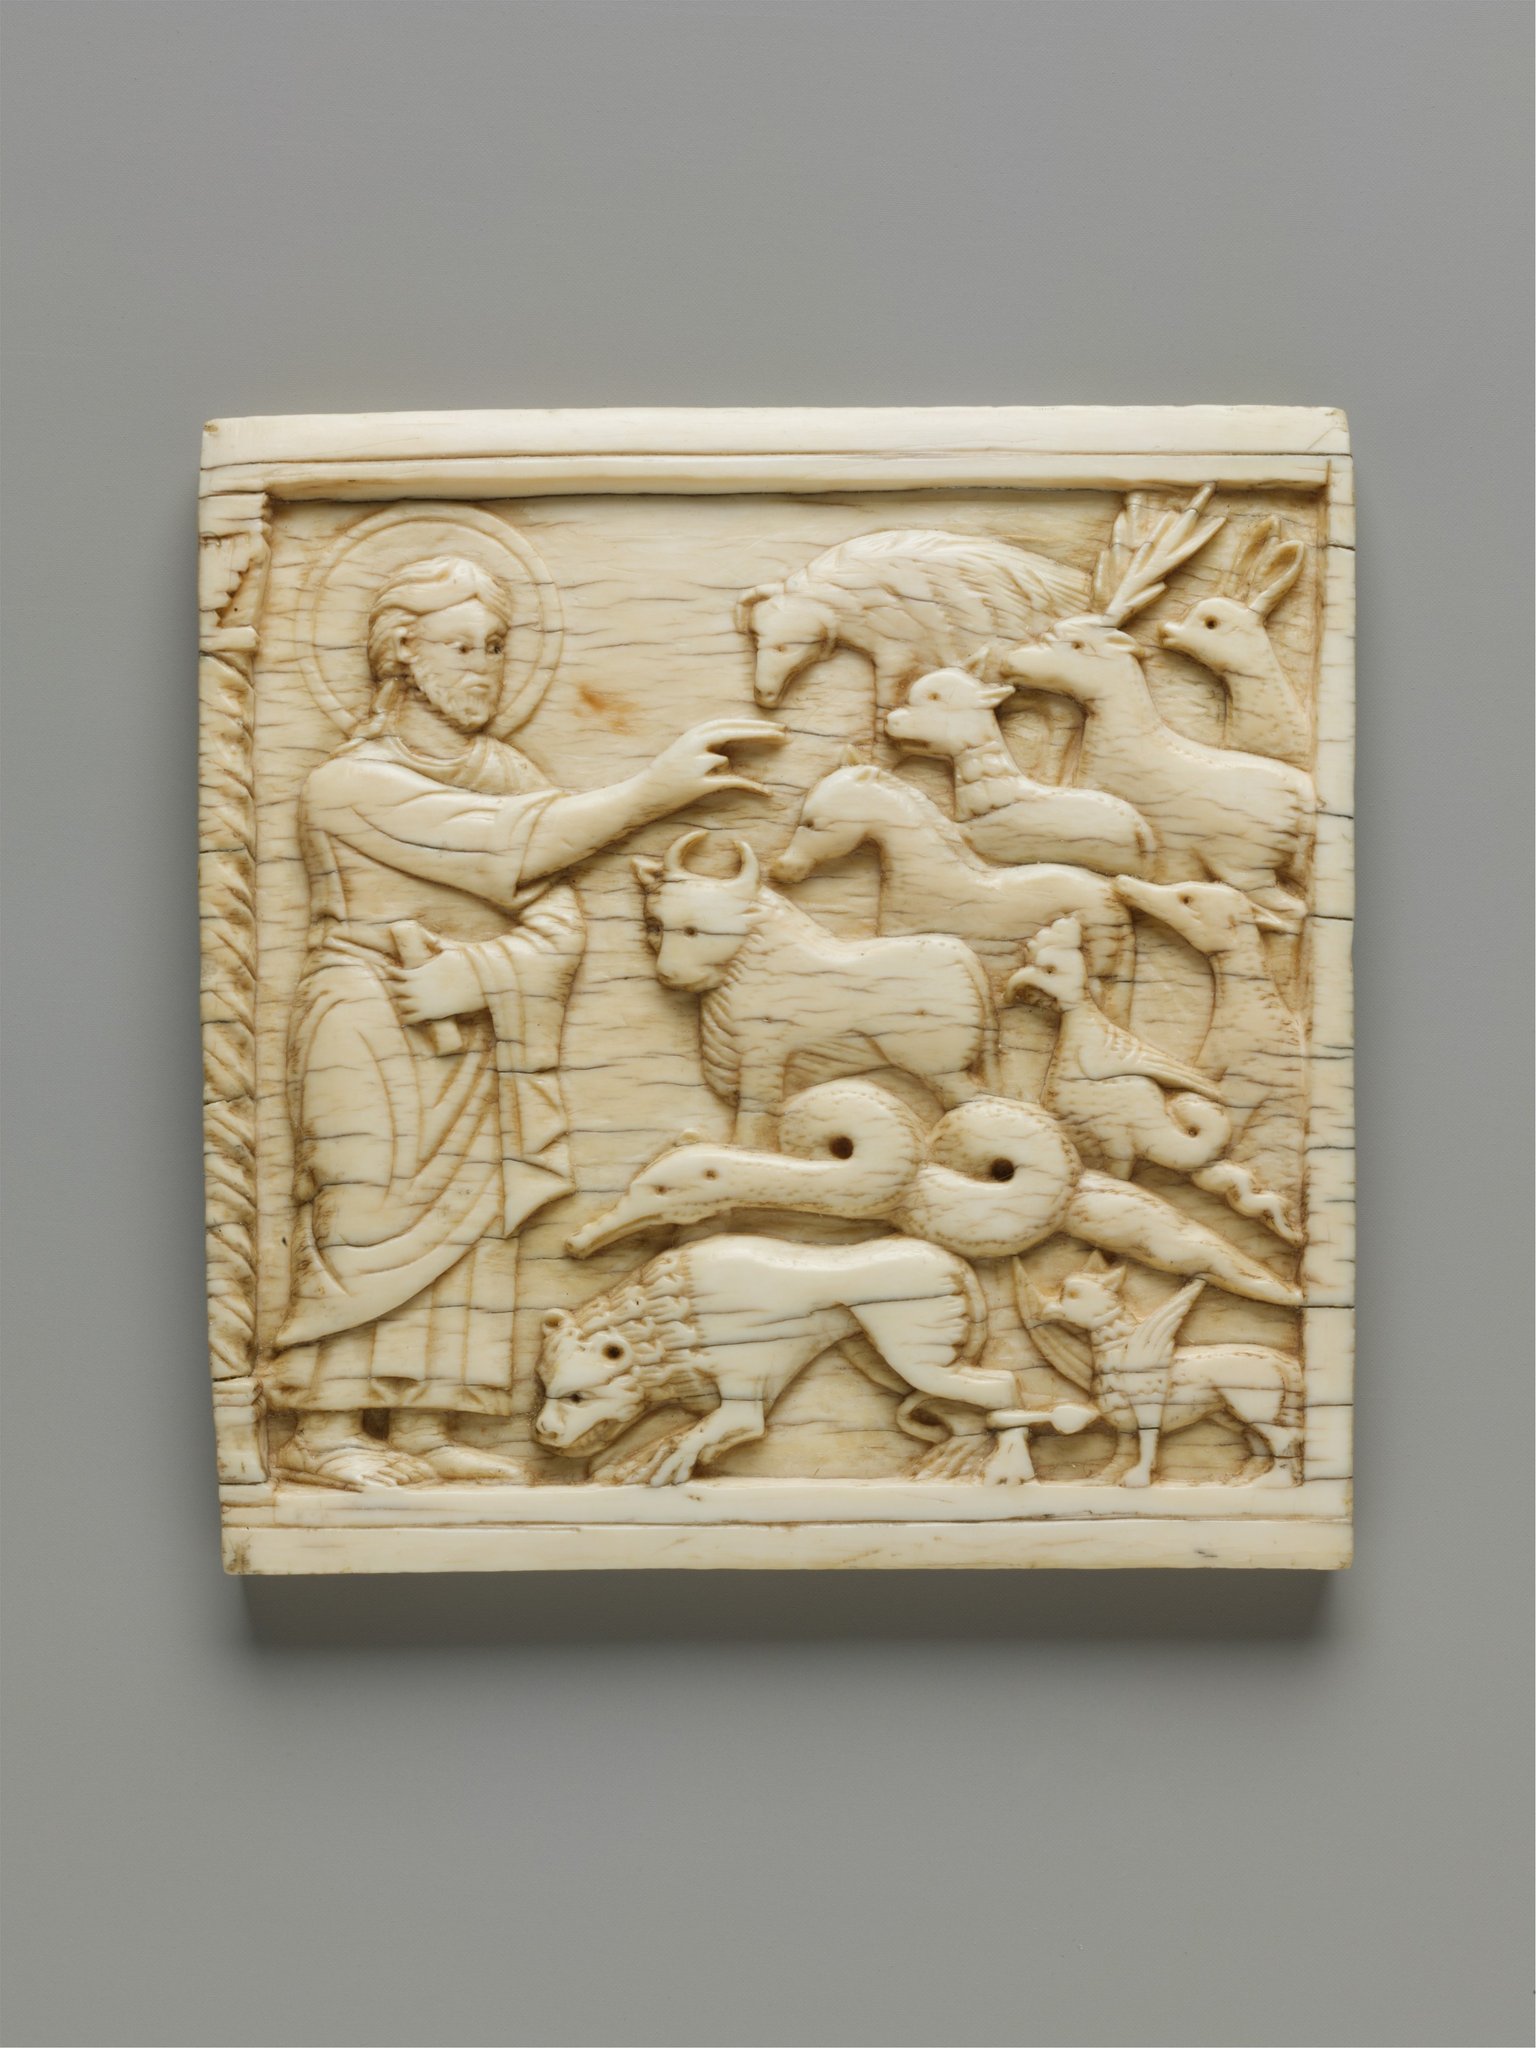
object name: plaque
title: Plaque with God Creating the Animals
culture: south italian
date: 1084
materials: ivory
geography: amalfi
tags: griffins,deer,lions,rams,snakes,ox,god the father